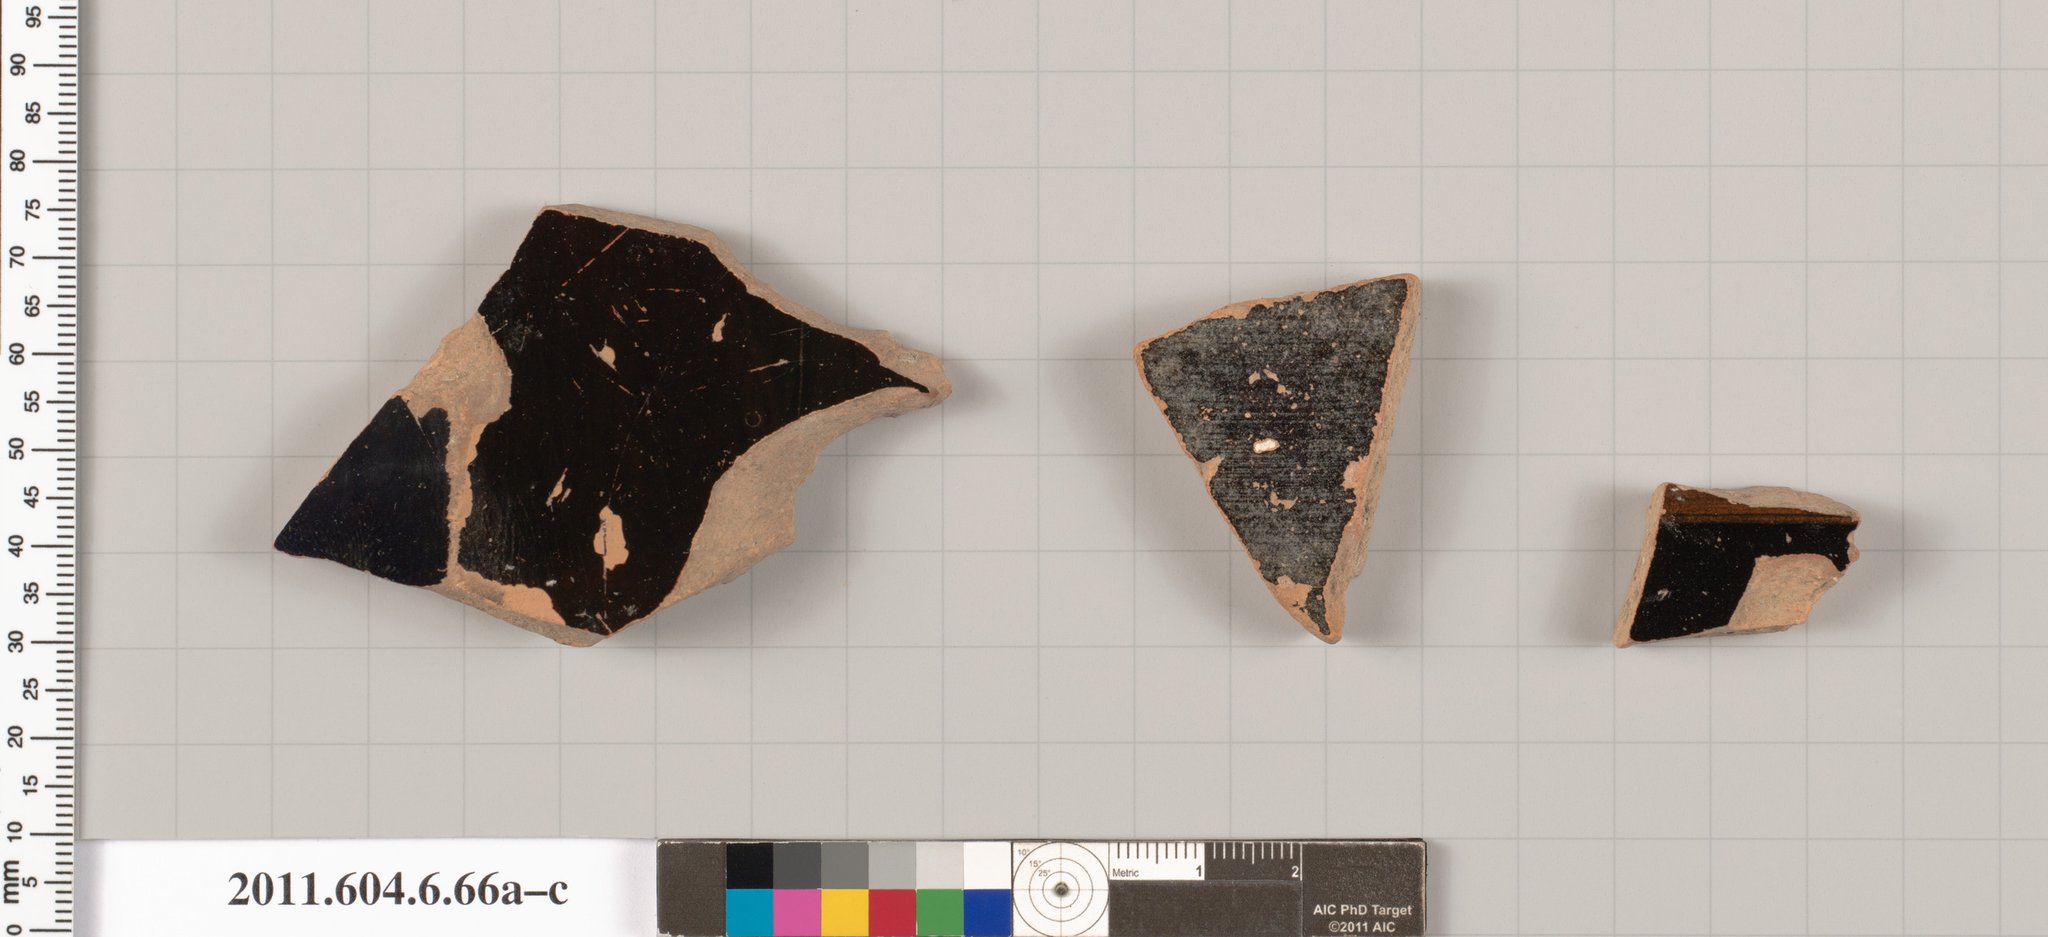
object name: krater fragment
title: Terracotta fragments of kraters (bowls for mixing wine and water)?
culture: greek, attic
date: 600-401 BCE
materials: terracotta